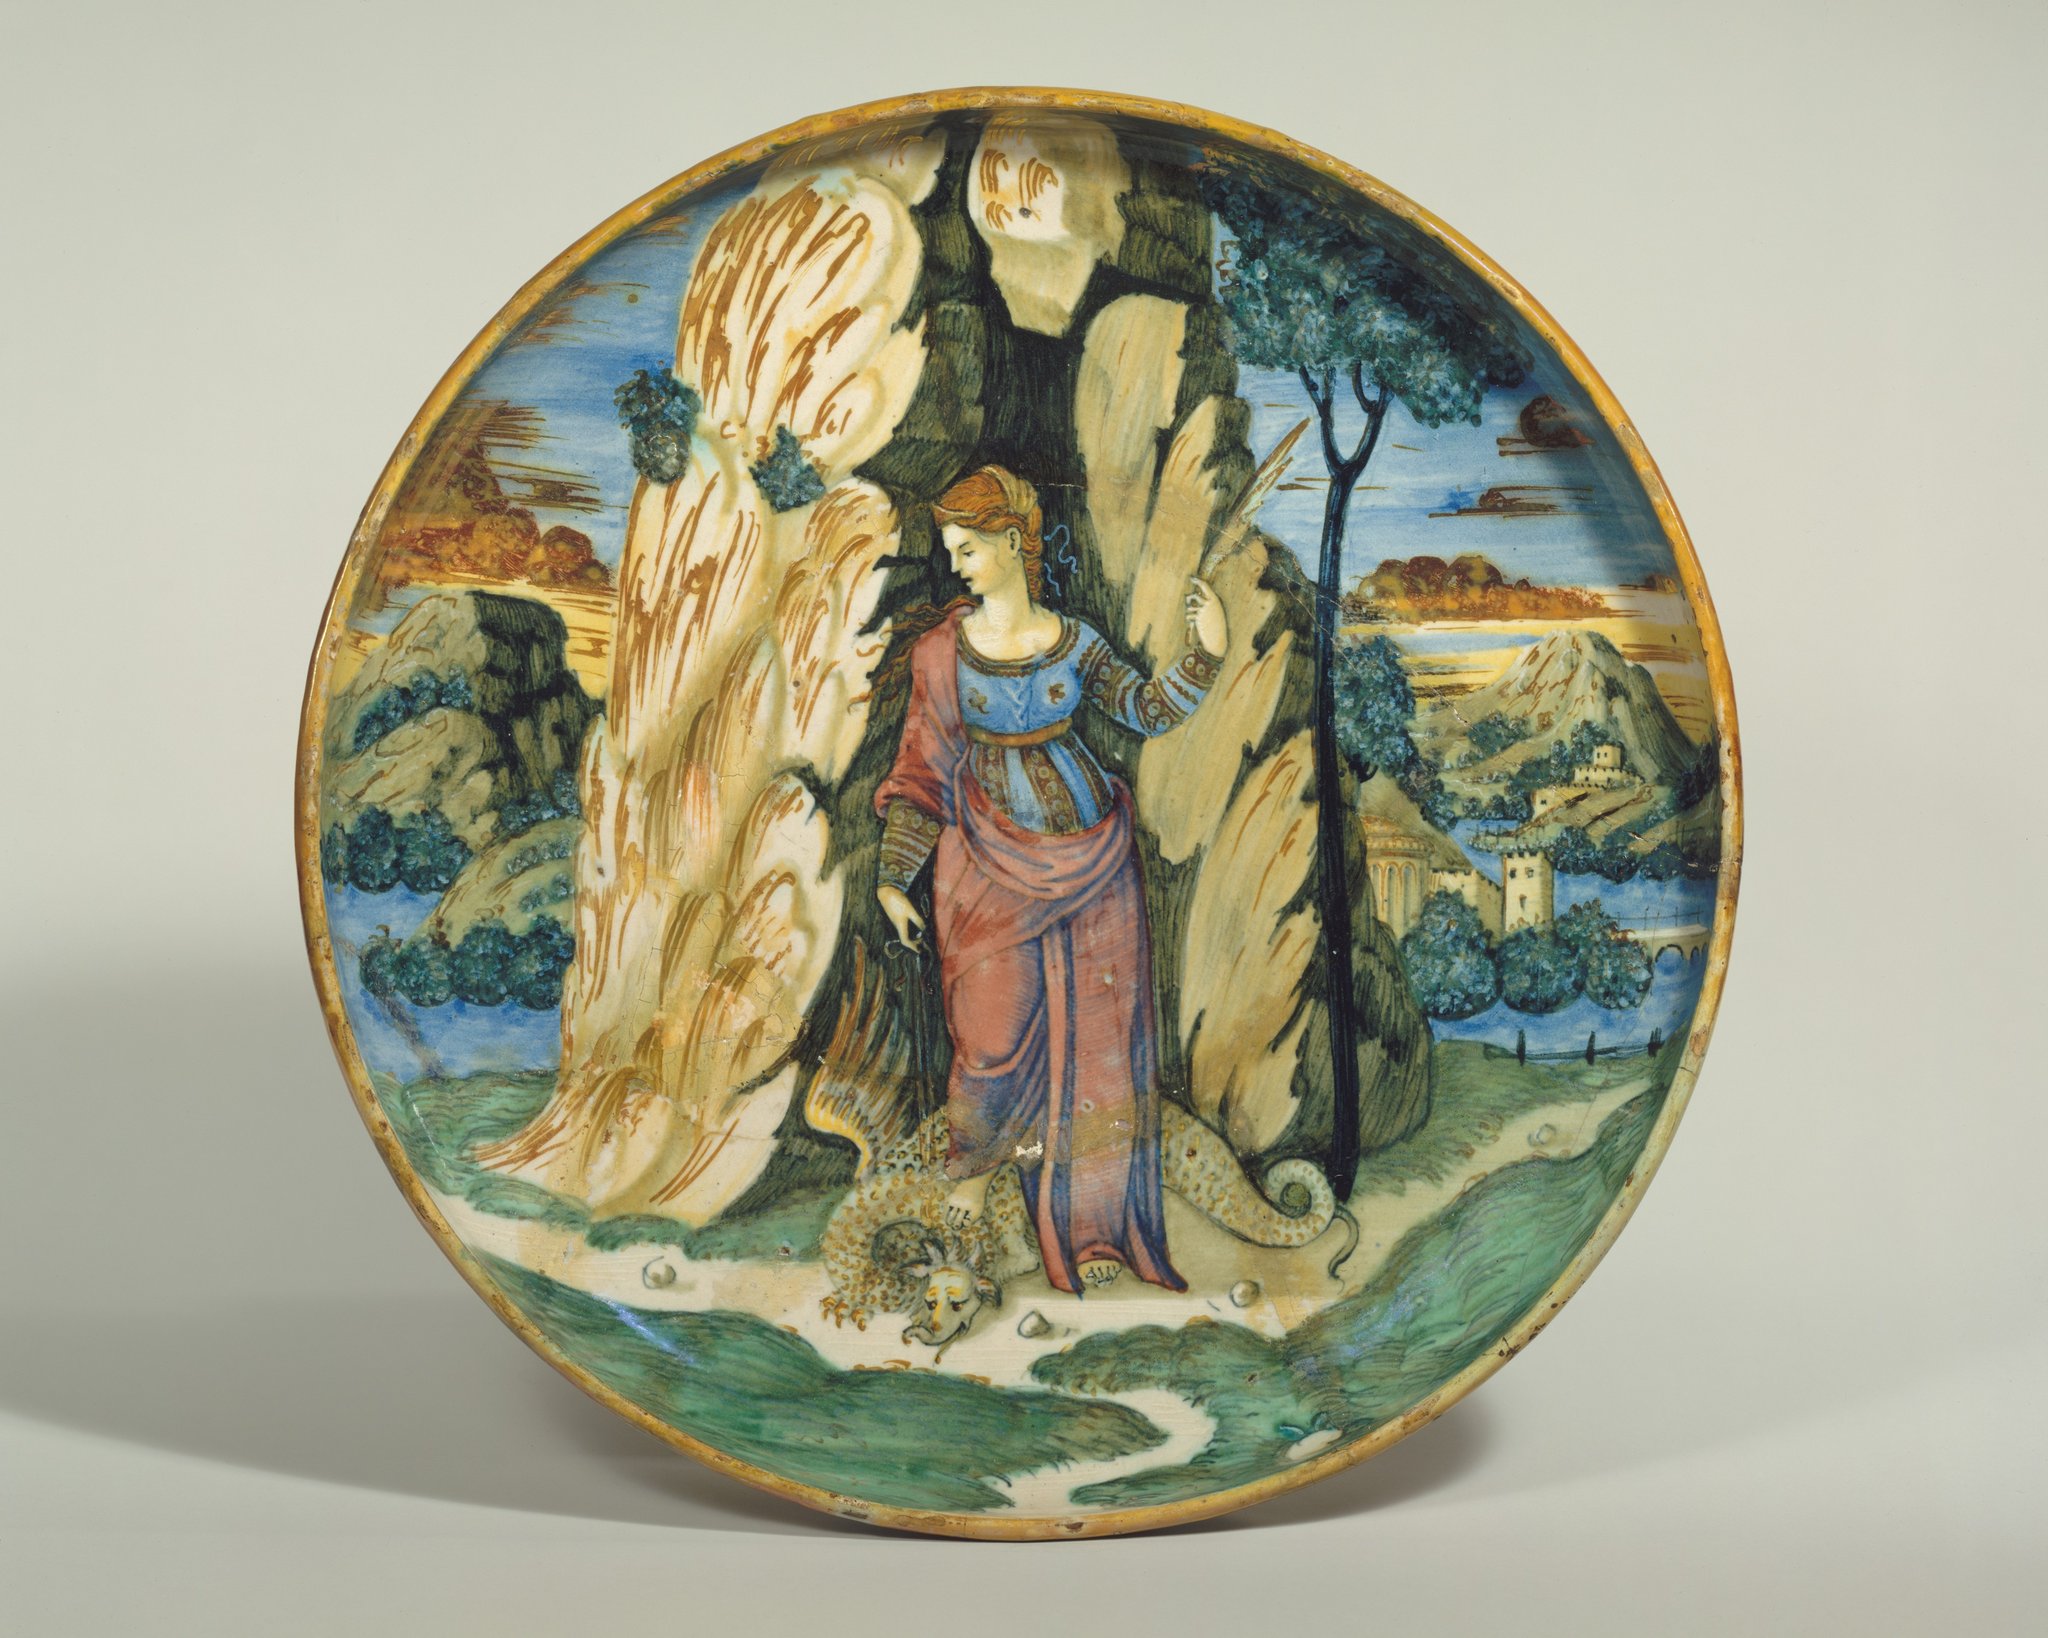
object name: dish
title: Dish (coppa): Saint Margaret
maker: maestro giorgio andreoli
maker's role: artist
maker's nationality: italian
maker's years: 1500-1550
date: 1527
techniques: maiolica, glazing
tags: women,dragons,saints